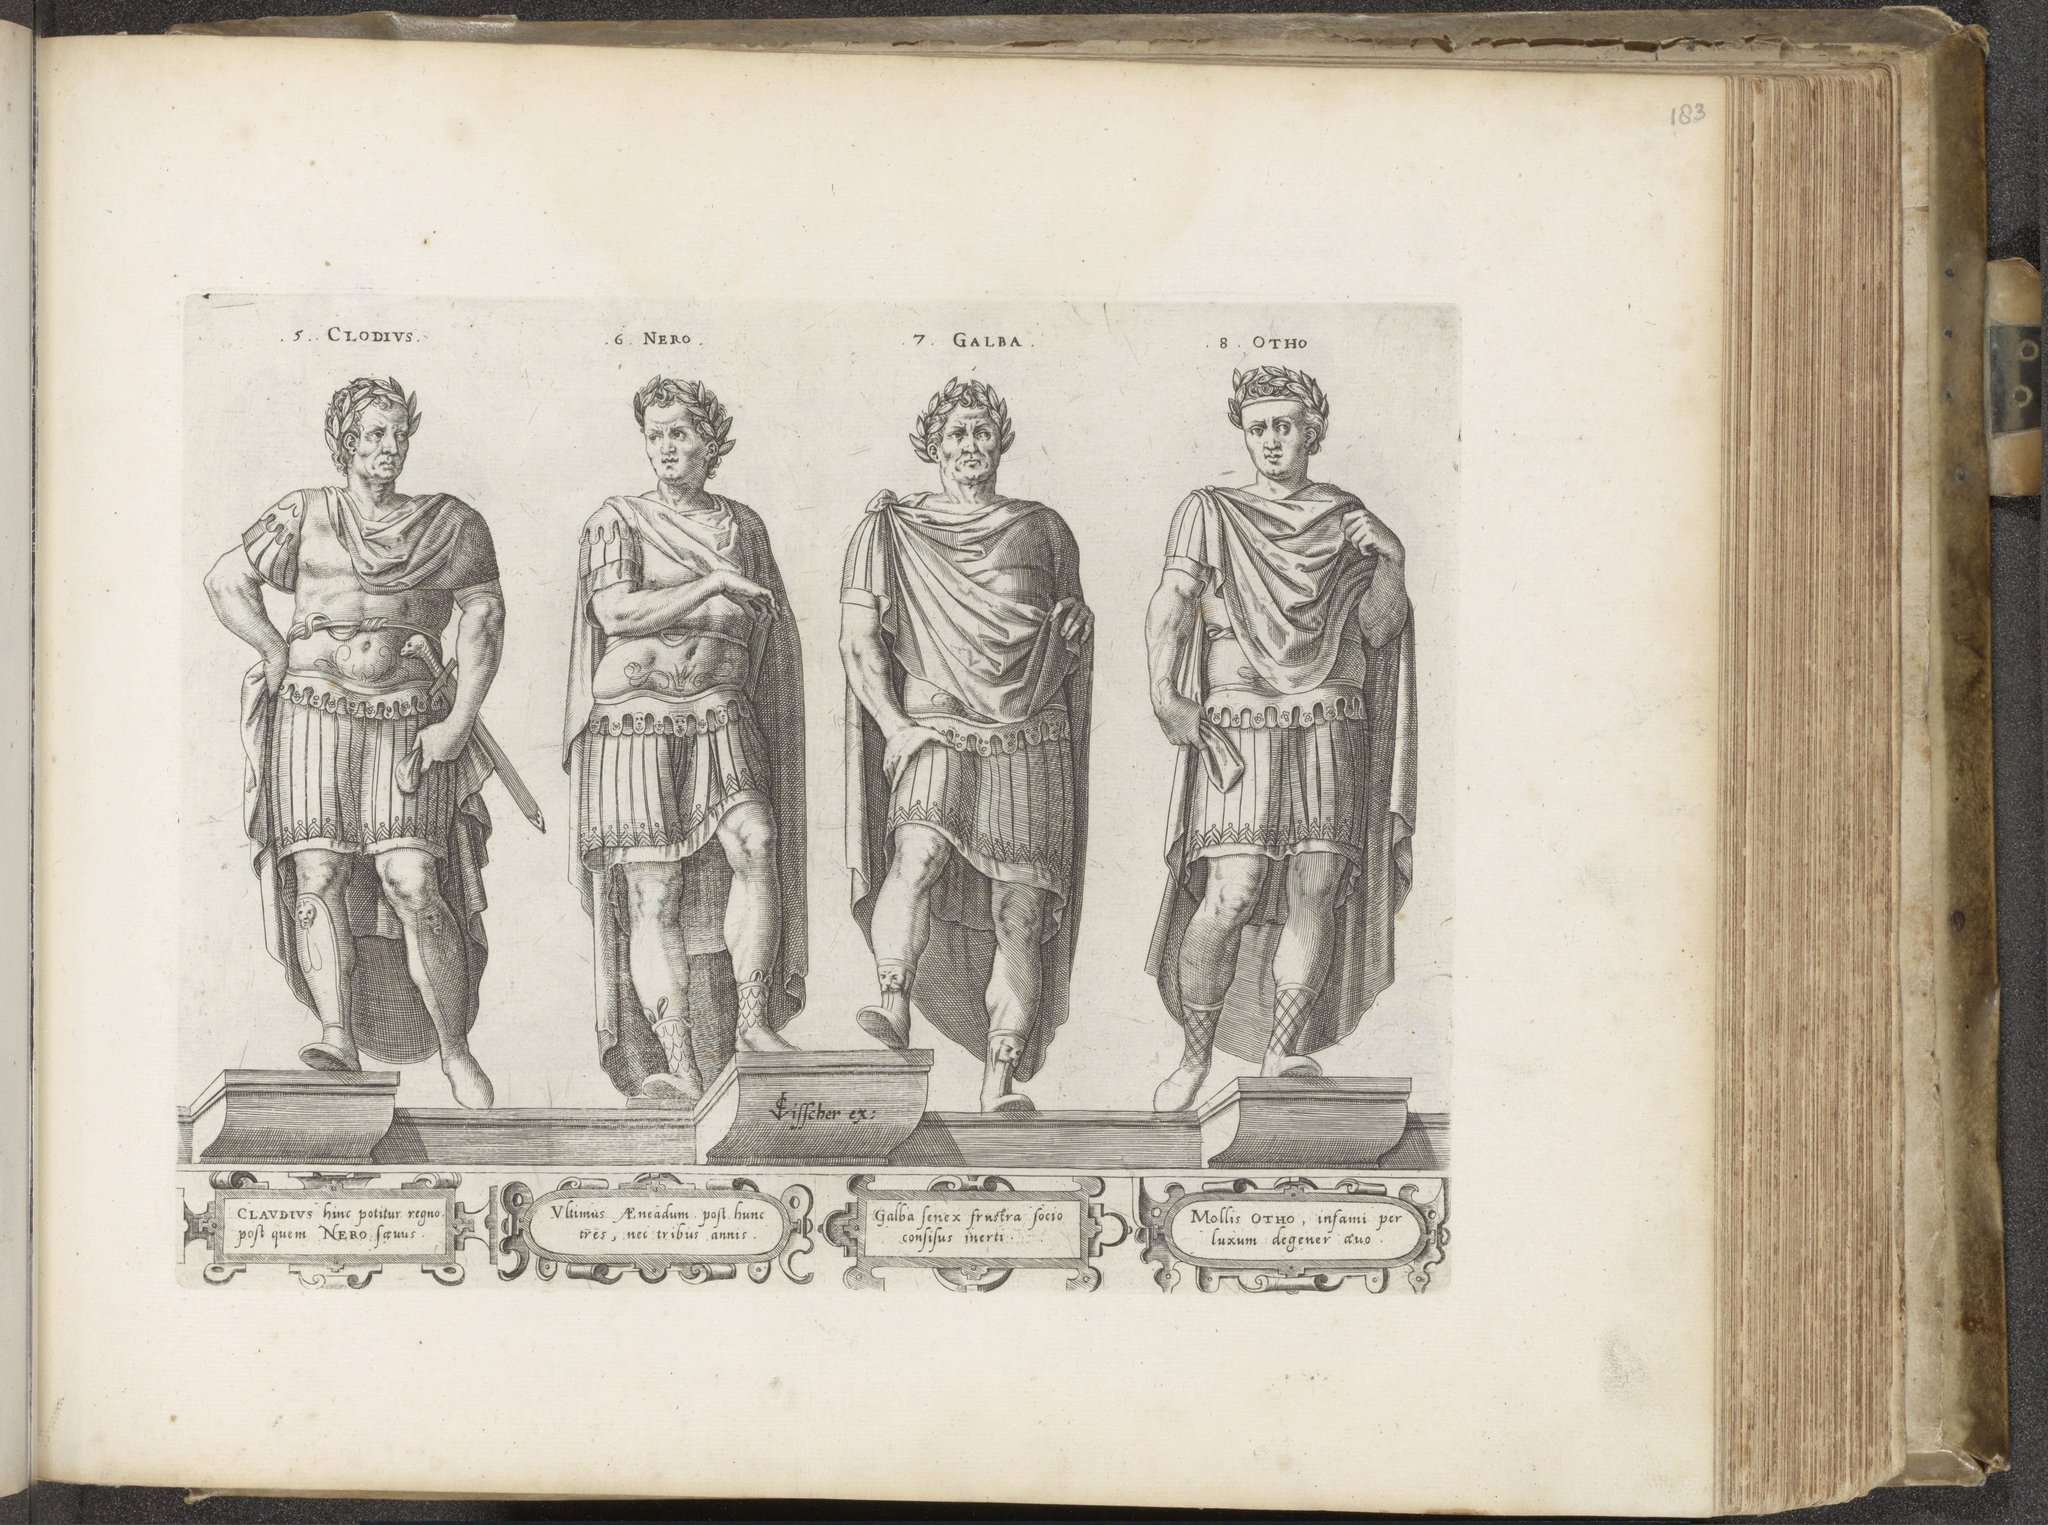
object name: album leaf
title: Twaalf Romeinse keizers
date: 1550-1650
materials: paper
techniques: engraving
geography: amsterdam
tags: claudius i (keizer van het romeinse rijk), galba (keizer van het romeinse rijk), ferento, brescello, keizer, otho (keizer van het romeinse rijk)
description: Vier consoles met de vijfde tot en met achtste keizer van het Romeinse Rijk. Afgebeeld ten voeten uit: Claudius I, Nero, Galba en Otho. Nero en Galba delen een console. De tekst in de cartouches daaronder zijn versregels uit de Monosticha de Ordine Imperatorum van de Latijns dichter Decimus Magnus Ausonius. De prent maakt deel uit van een album.